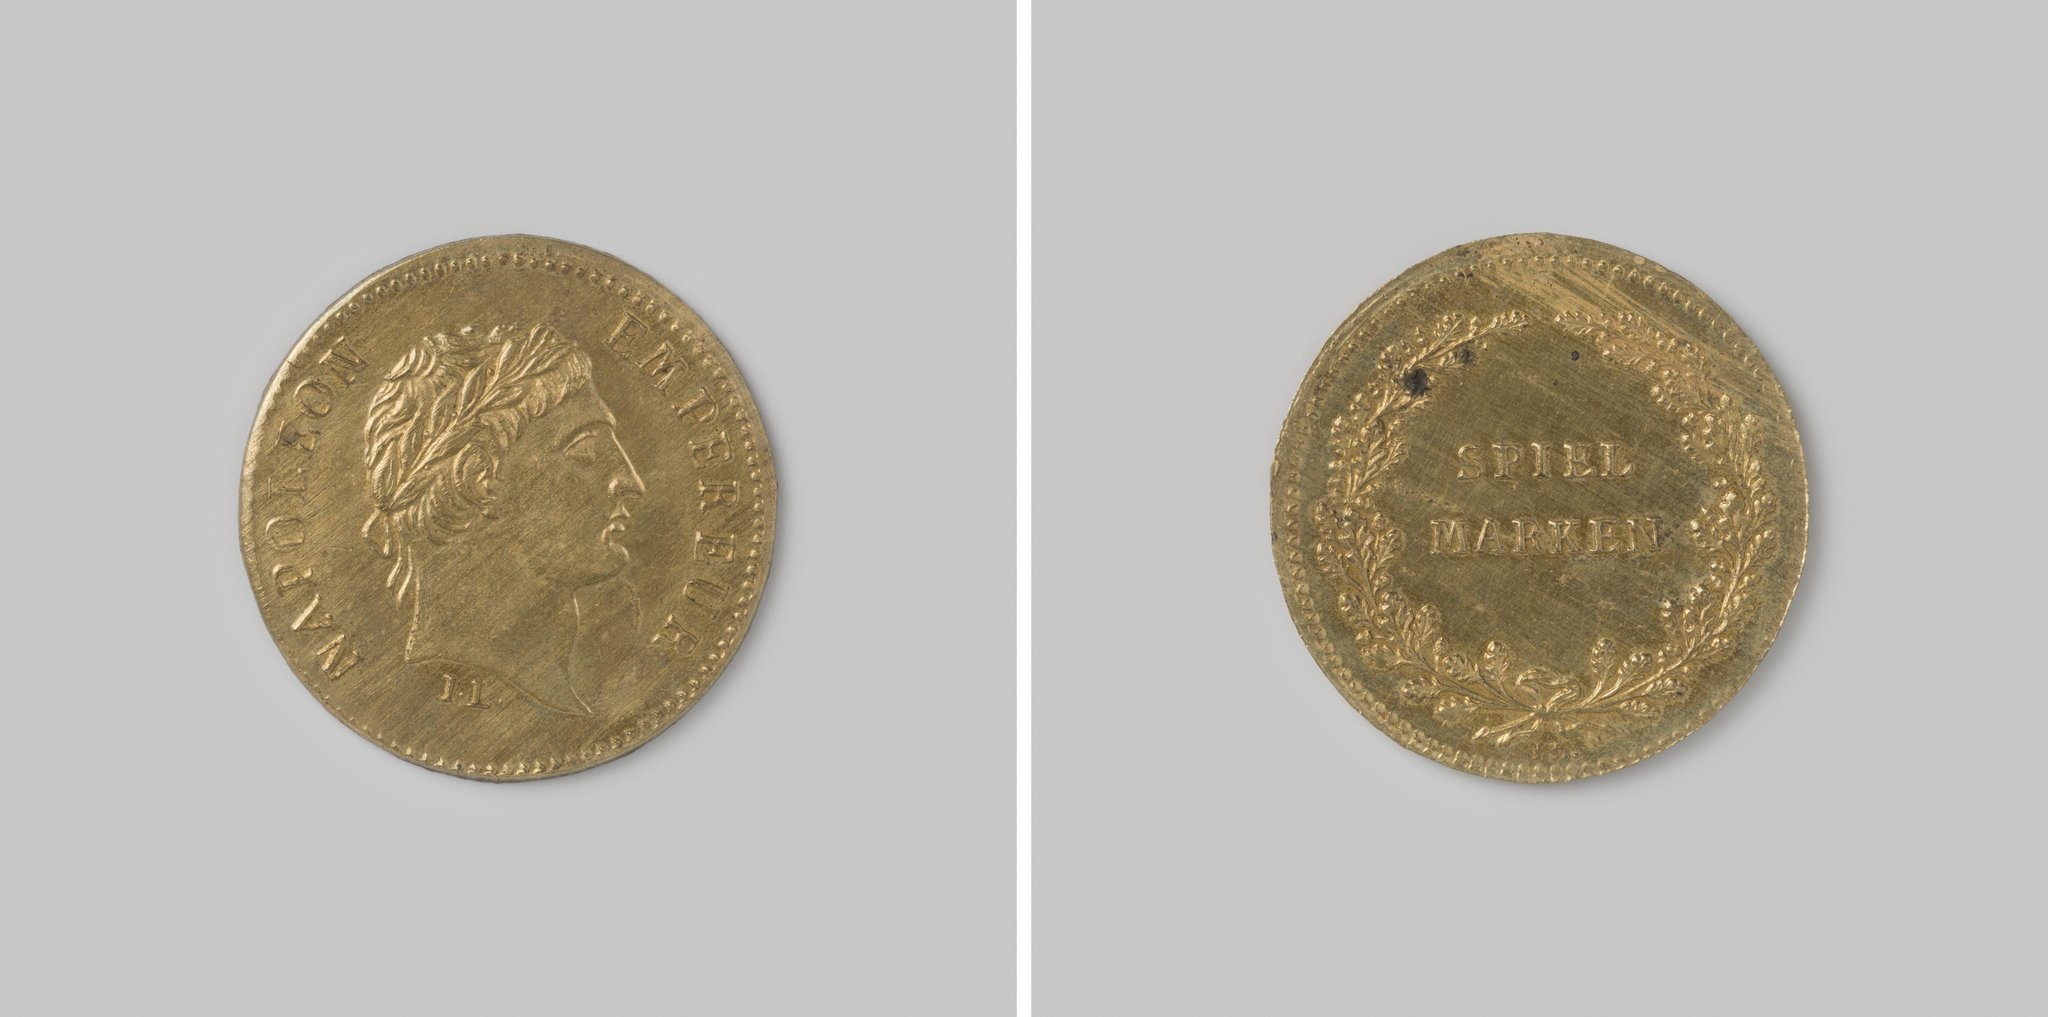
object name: history medal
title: Speelpenning uit Neurenberg met Keizer Napoleon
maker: johann jakob lauer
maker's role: die cutter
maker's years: 1788-1863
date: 1804-1813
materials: brass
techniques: striking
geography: nuremberg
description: Messing penning, op de voorzijde het portret van Napoleon naar rechts met omschrift, op de keerzijde twee regels tekst tussen samengestrikte eikentakken.